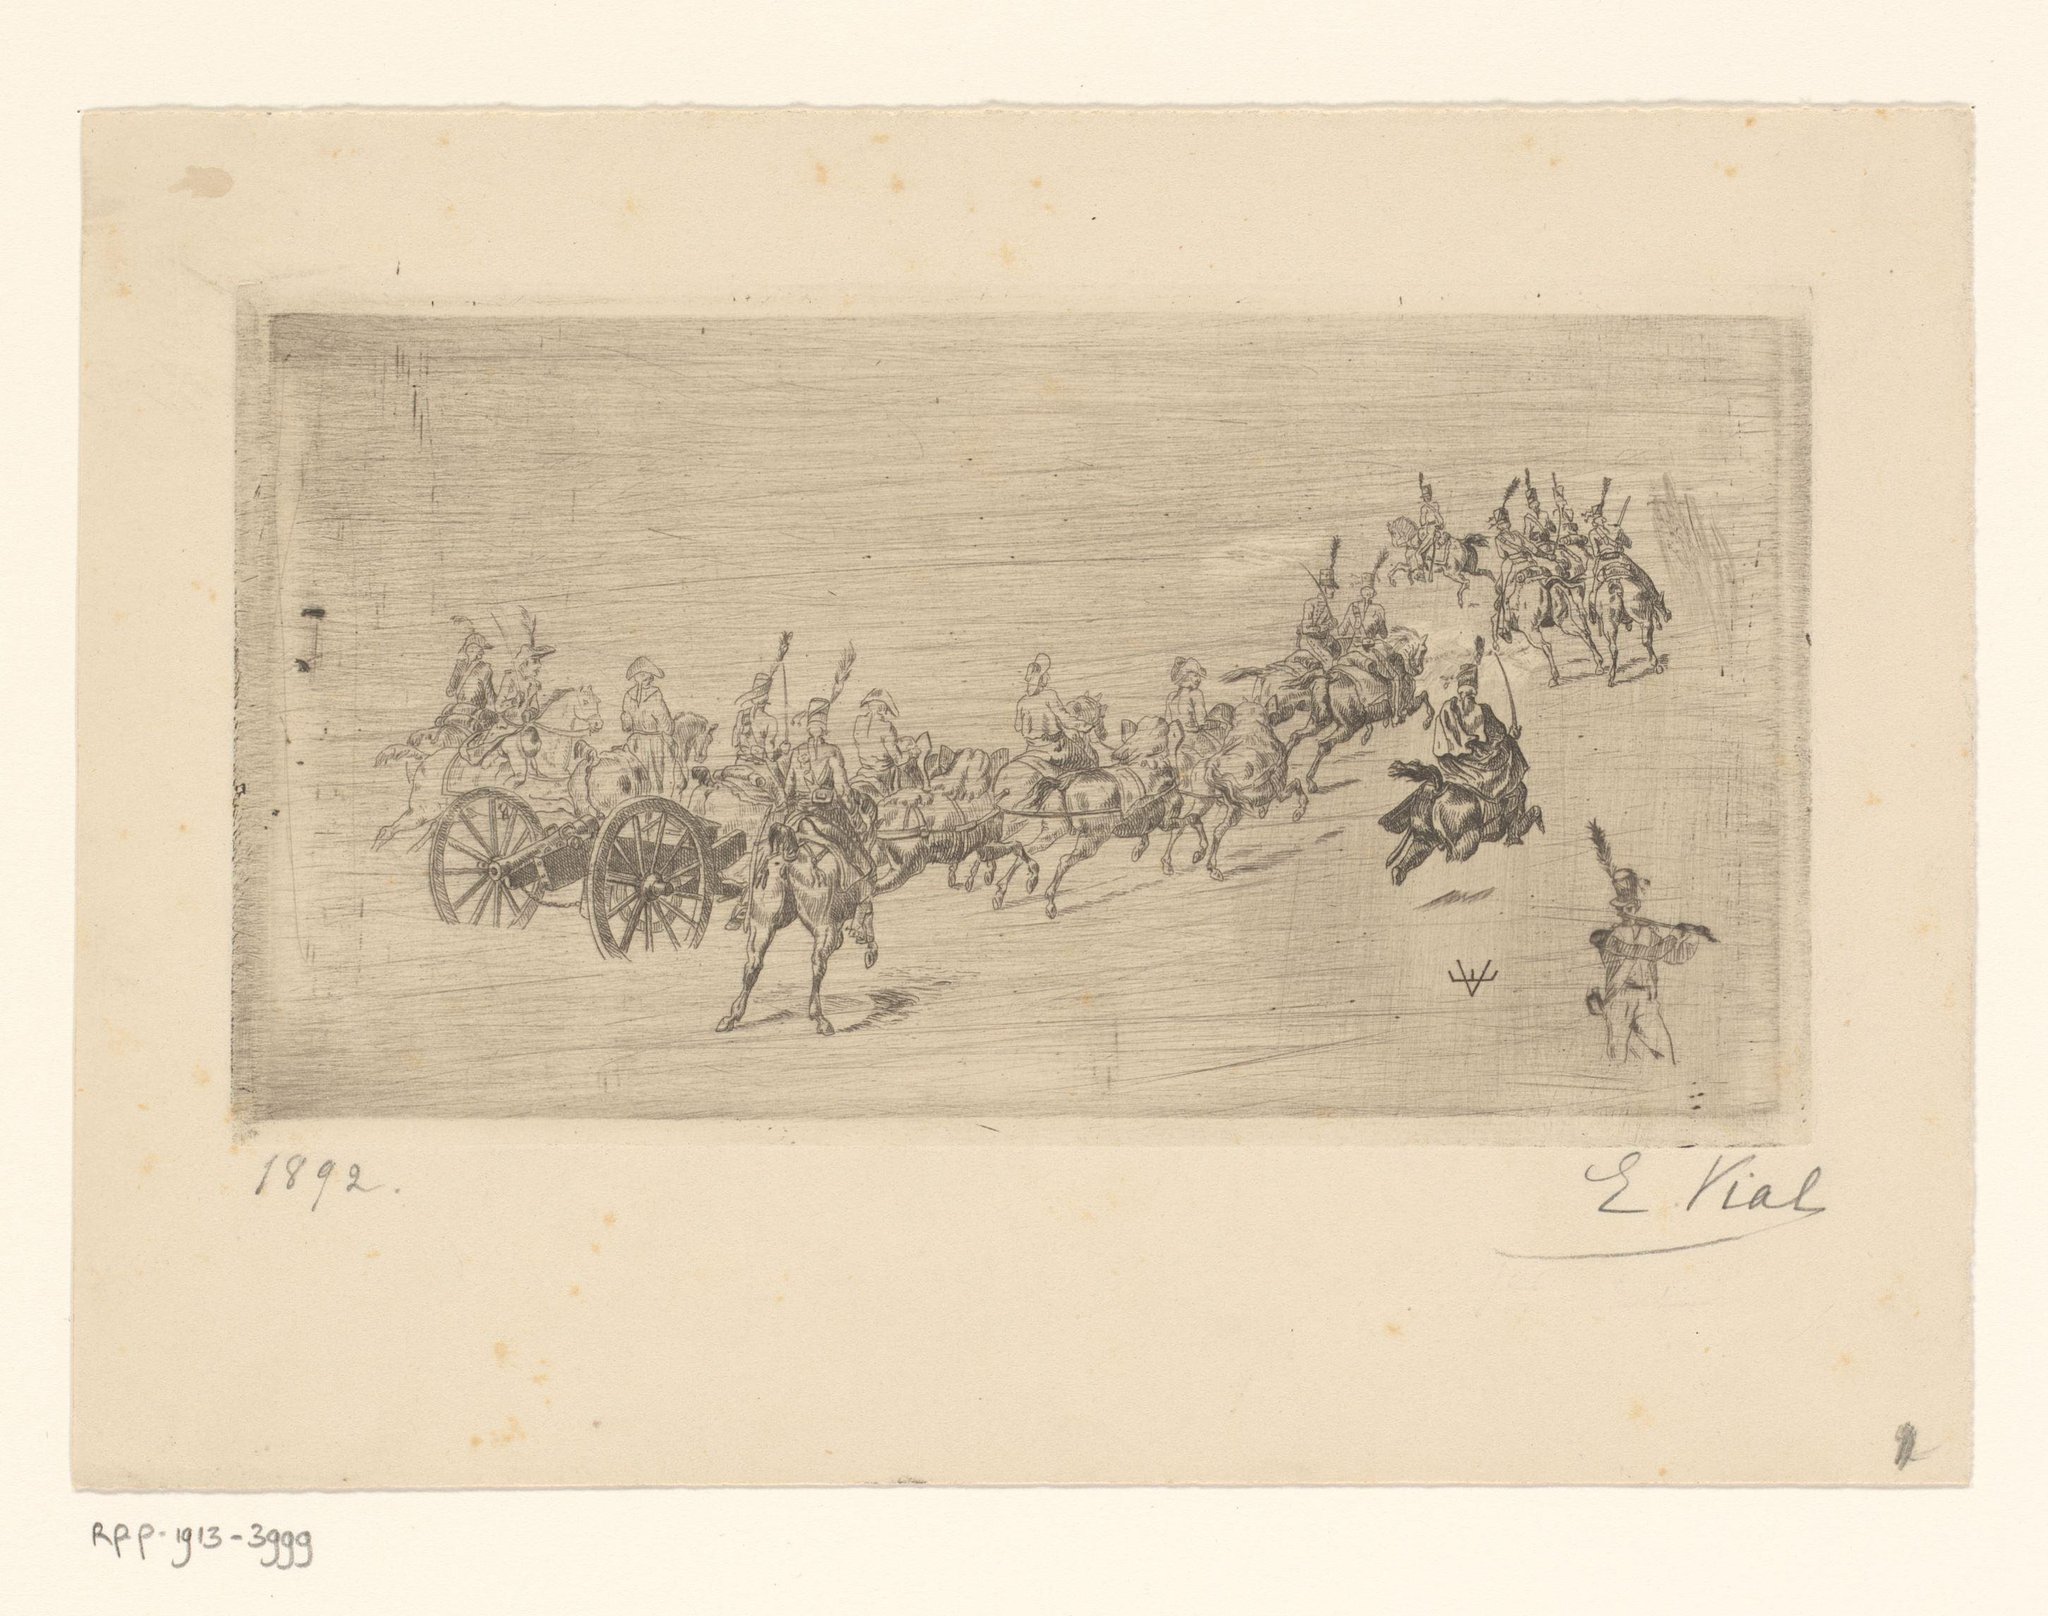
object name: print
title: Groep soldaten te paard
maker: eléonore vial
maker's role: print maker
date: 1892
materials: paper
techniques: etching, intaglio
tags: riding a horse, ass, or mule; rider, horseman, battle, the soldier; the soldier's life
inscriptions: inscription: ‘1892’, collector's mark: Lugt 2228